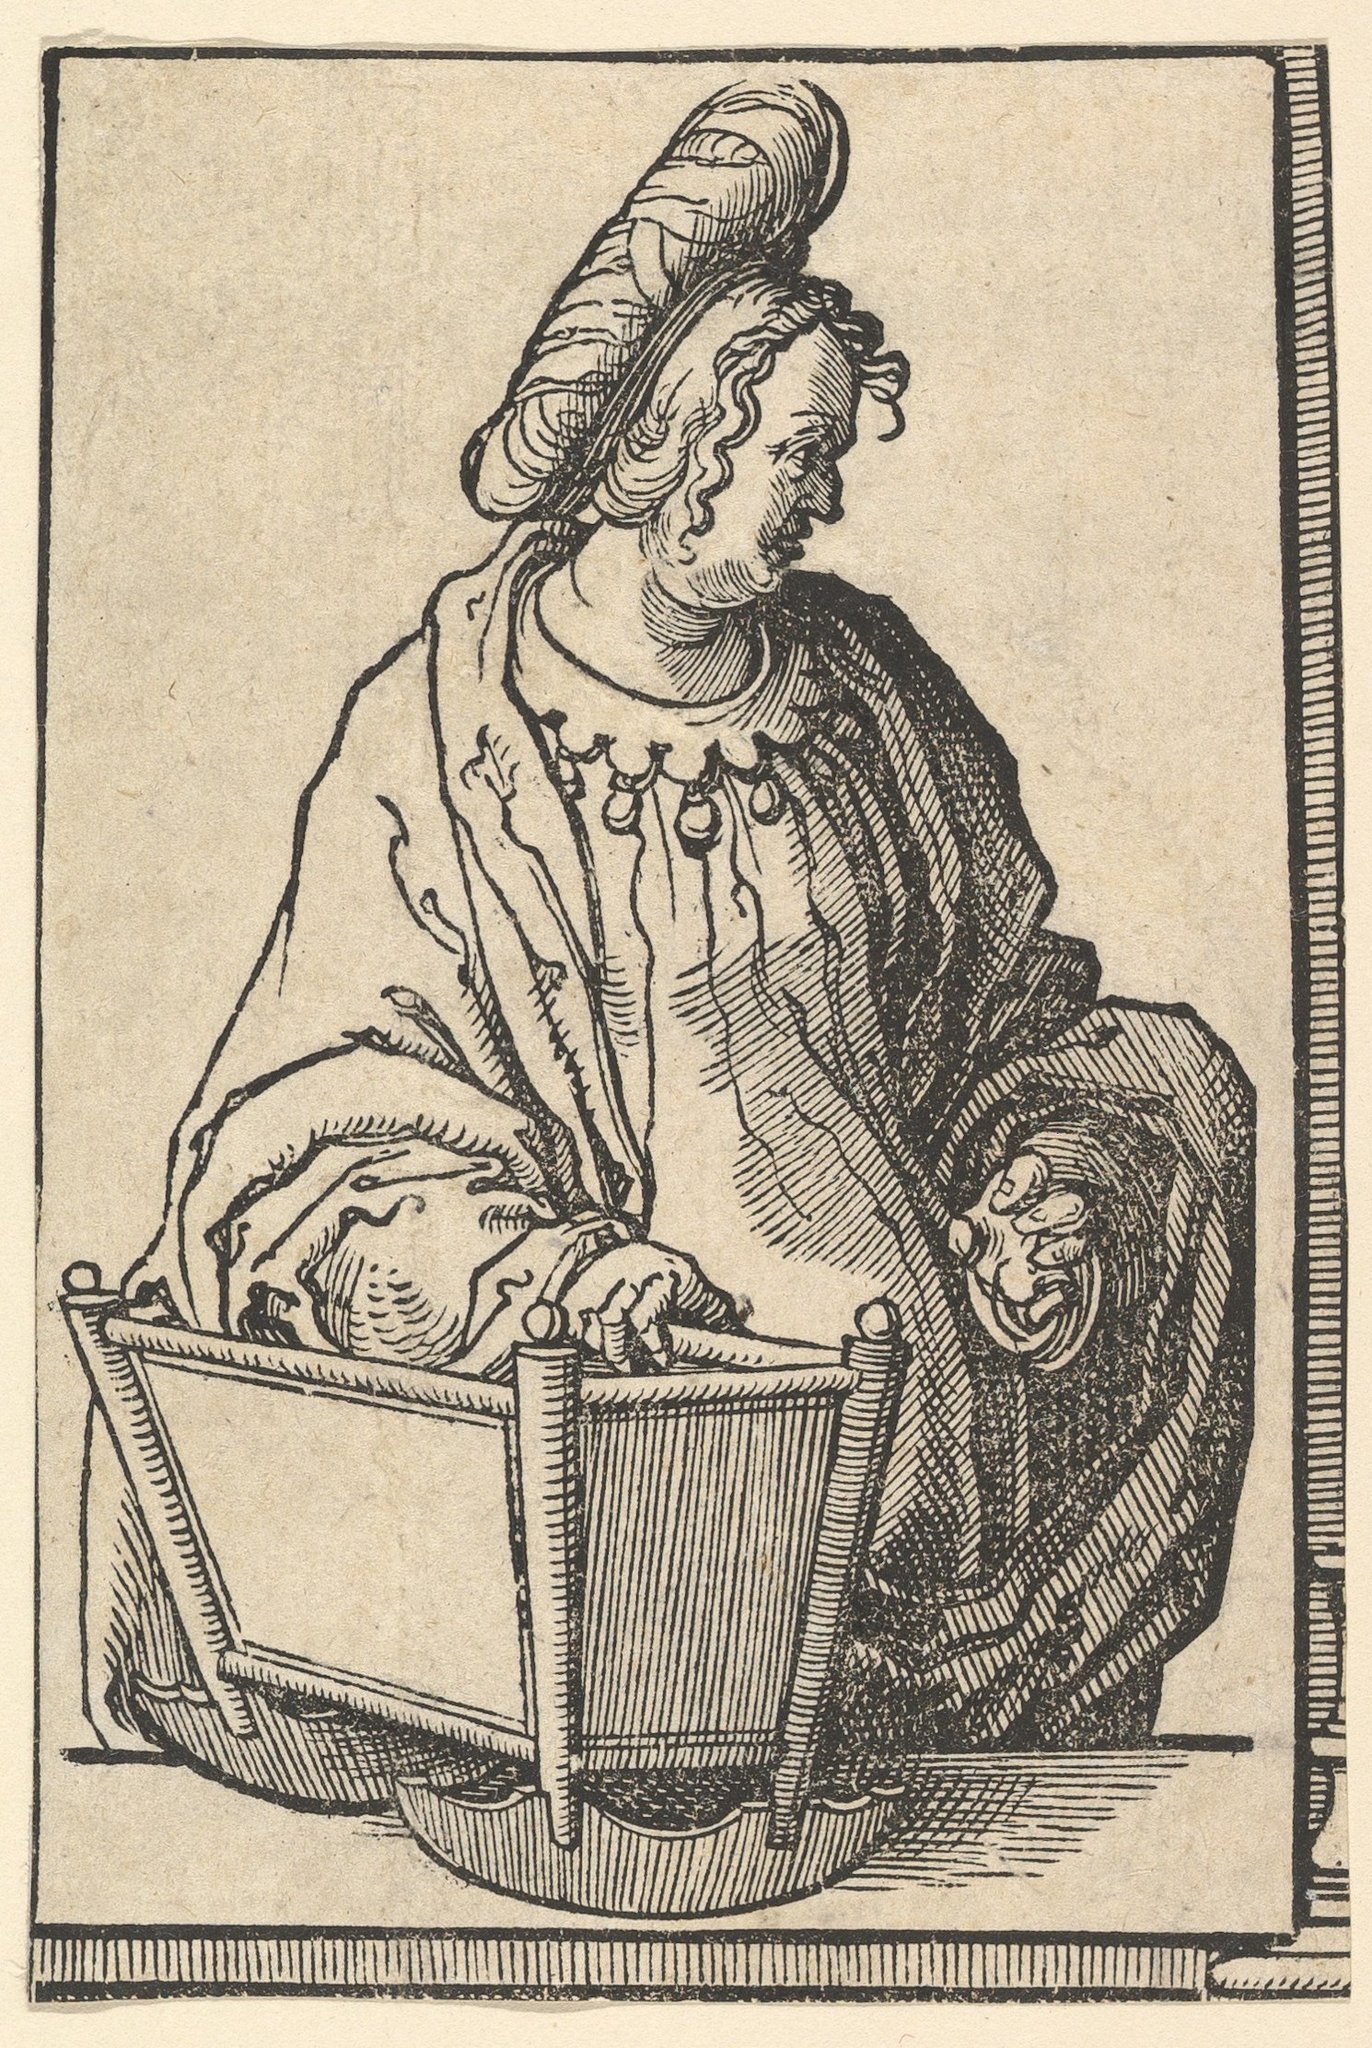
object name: print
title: Samarian Sibyl, from the series of Sibyls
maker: lucas van leyden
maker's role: artist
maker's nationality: netherlandish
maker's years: 1494-1533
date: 1530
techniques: woodcut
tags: sibyl